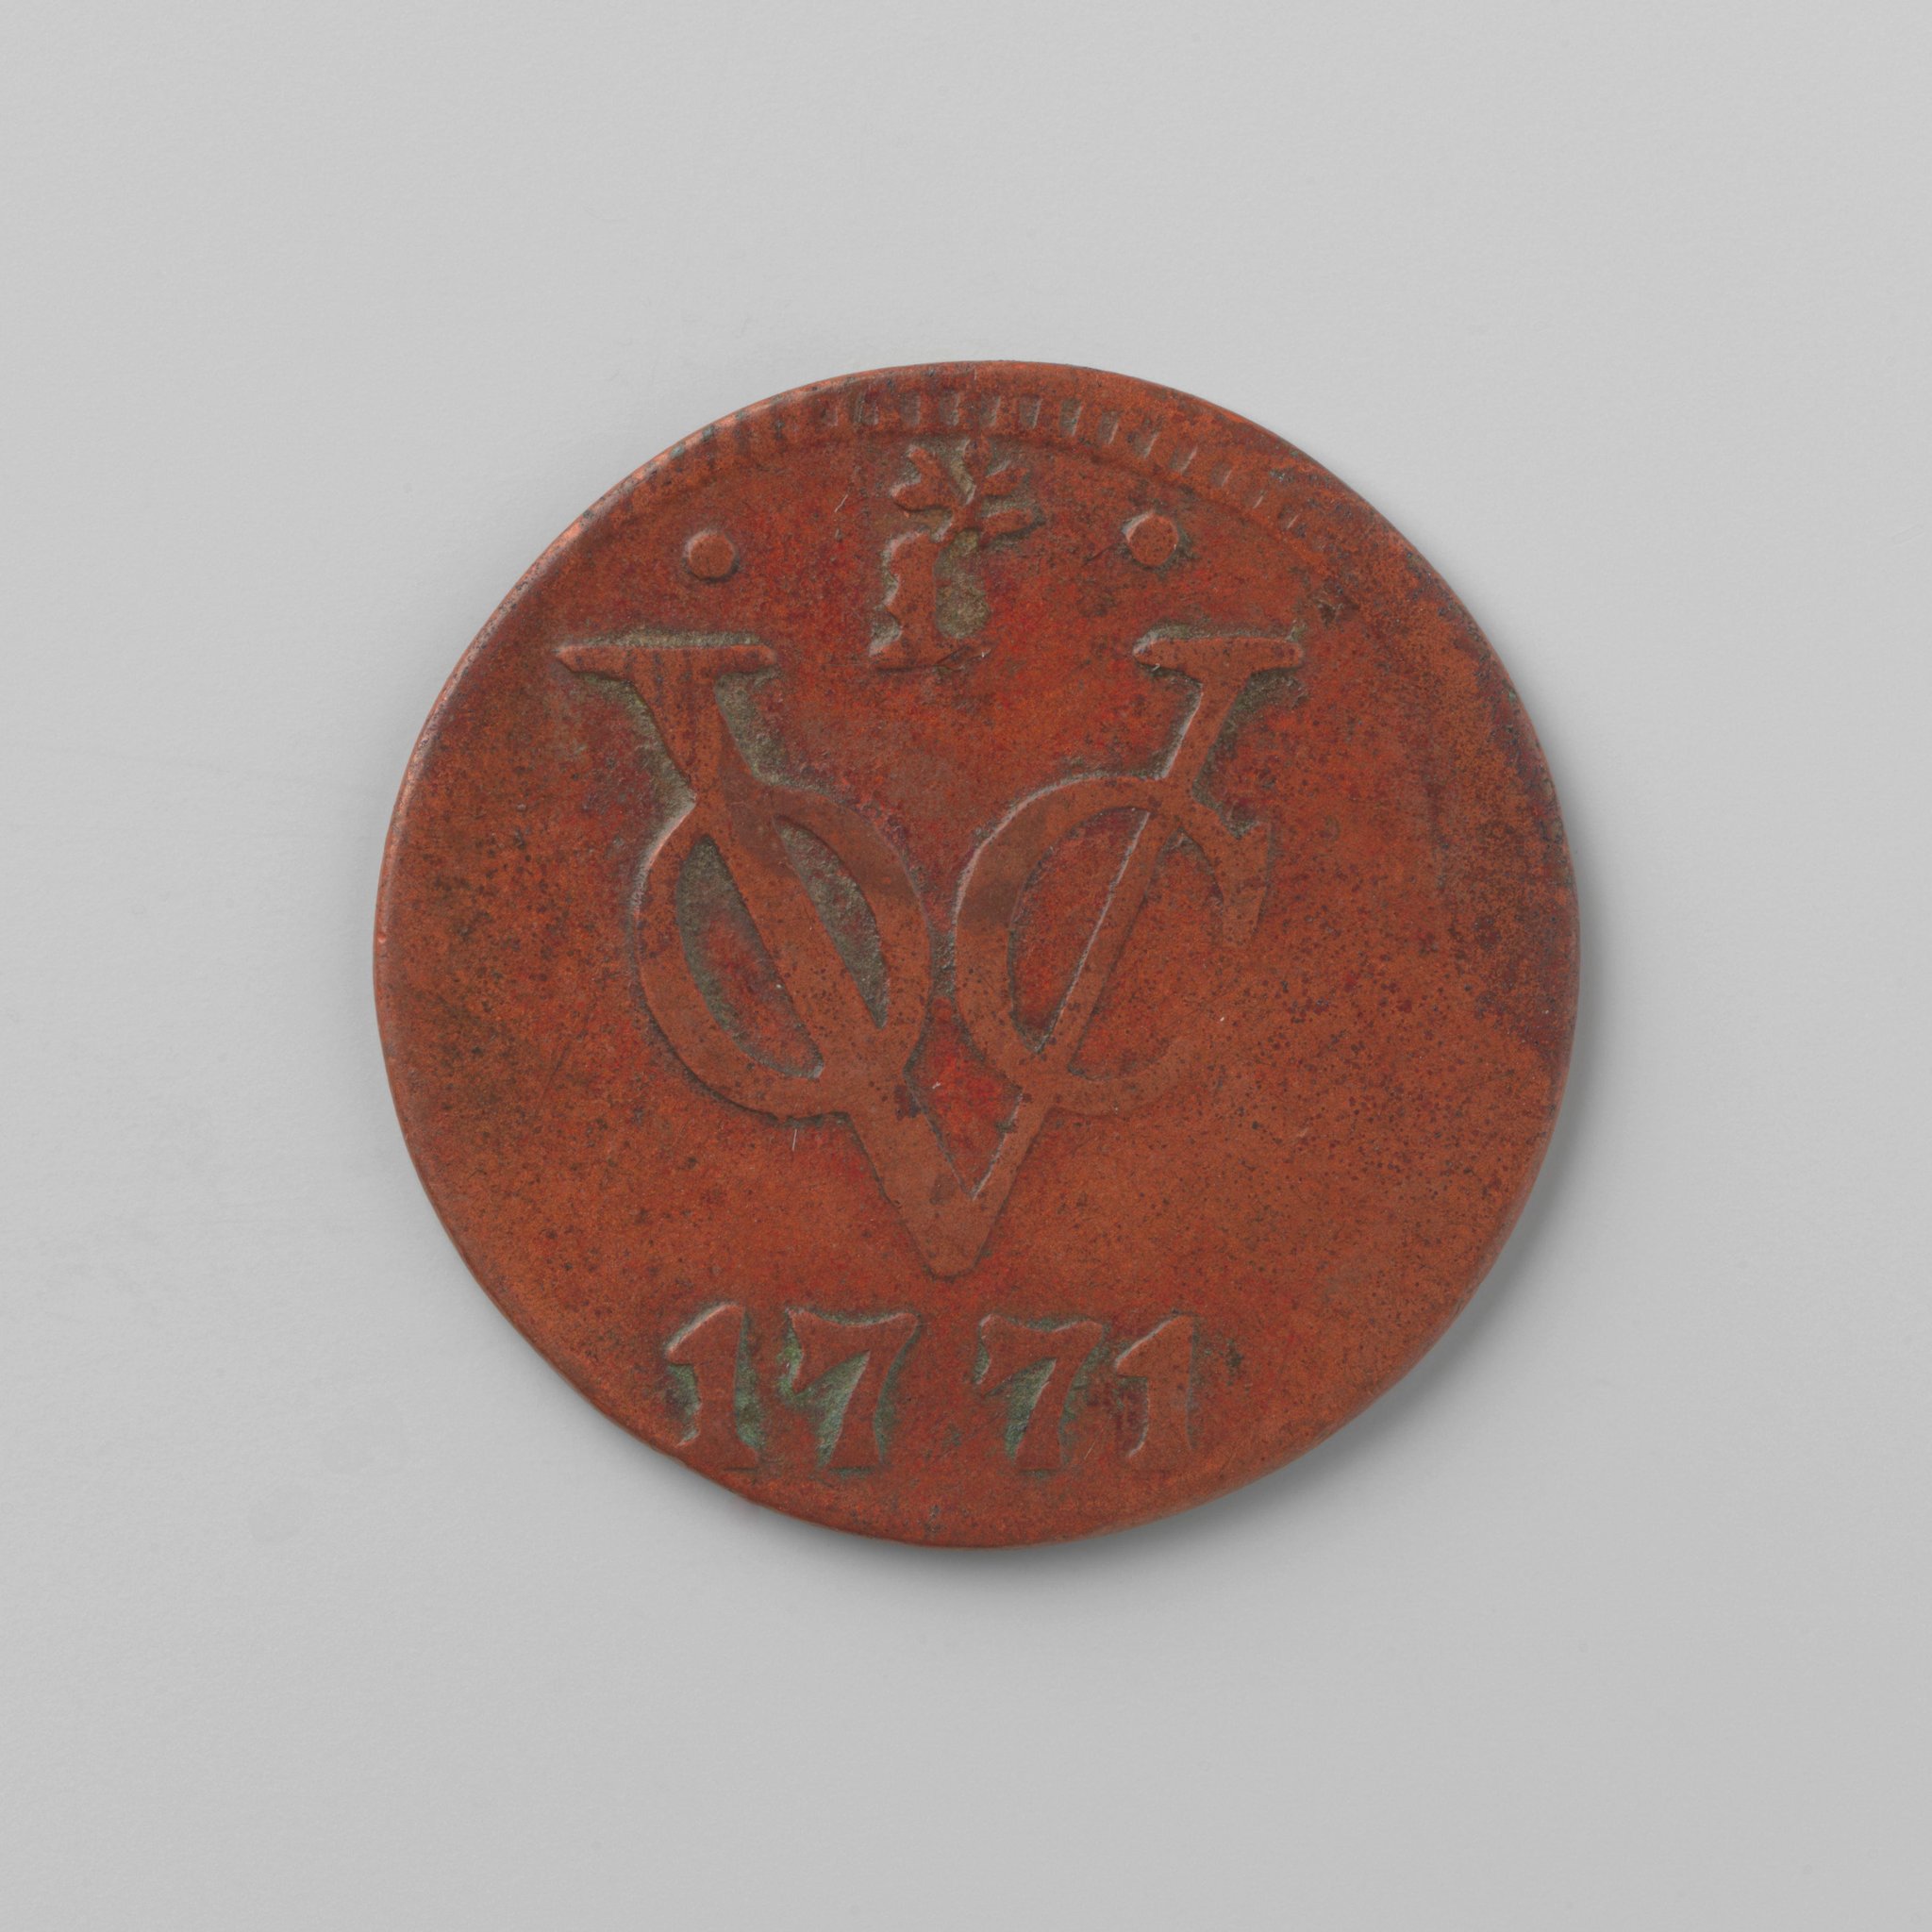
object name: coin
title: VOC, duit Gelderland,1771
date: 1771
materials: copper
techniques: striking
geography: harderwijk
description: Koperen munt. Voorzijde: tussen wapenspreuk gekroond wapenschild van Gelderland. Keerzijde: monogram van de VOC, waarboven muntmeesterteken en waaronder jaartal. Gladde rand.